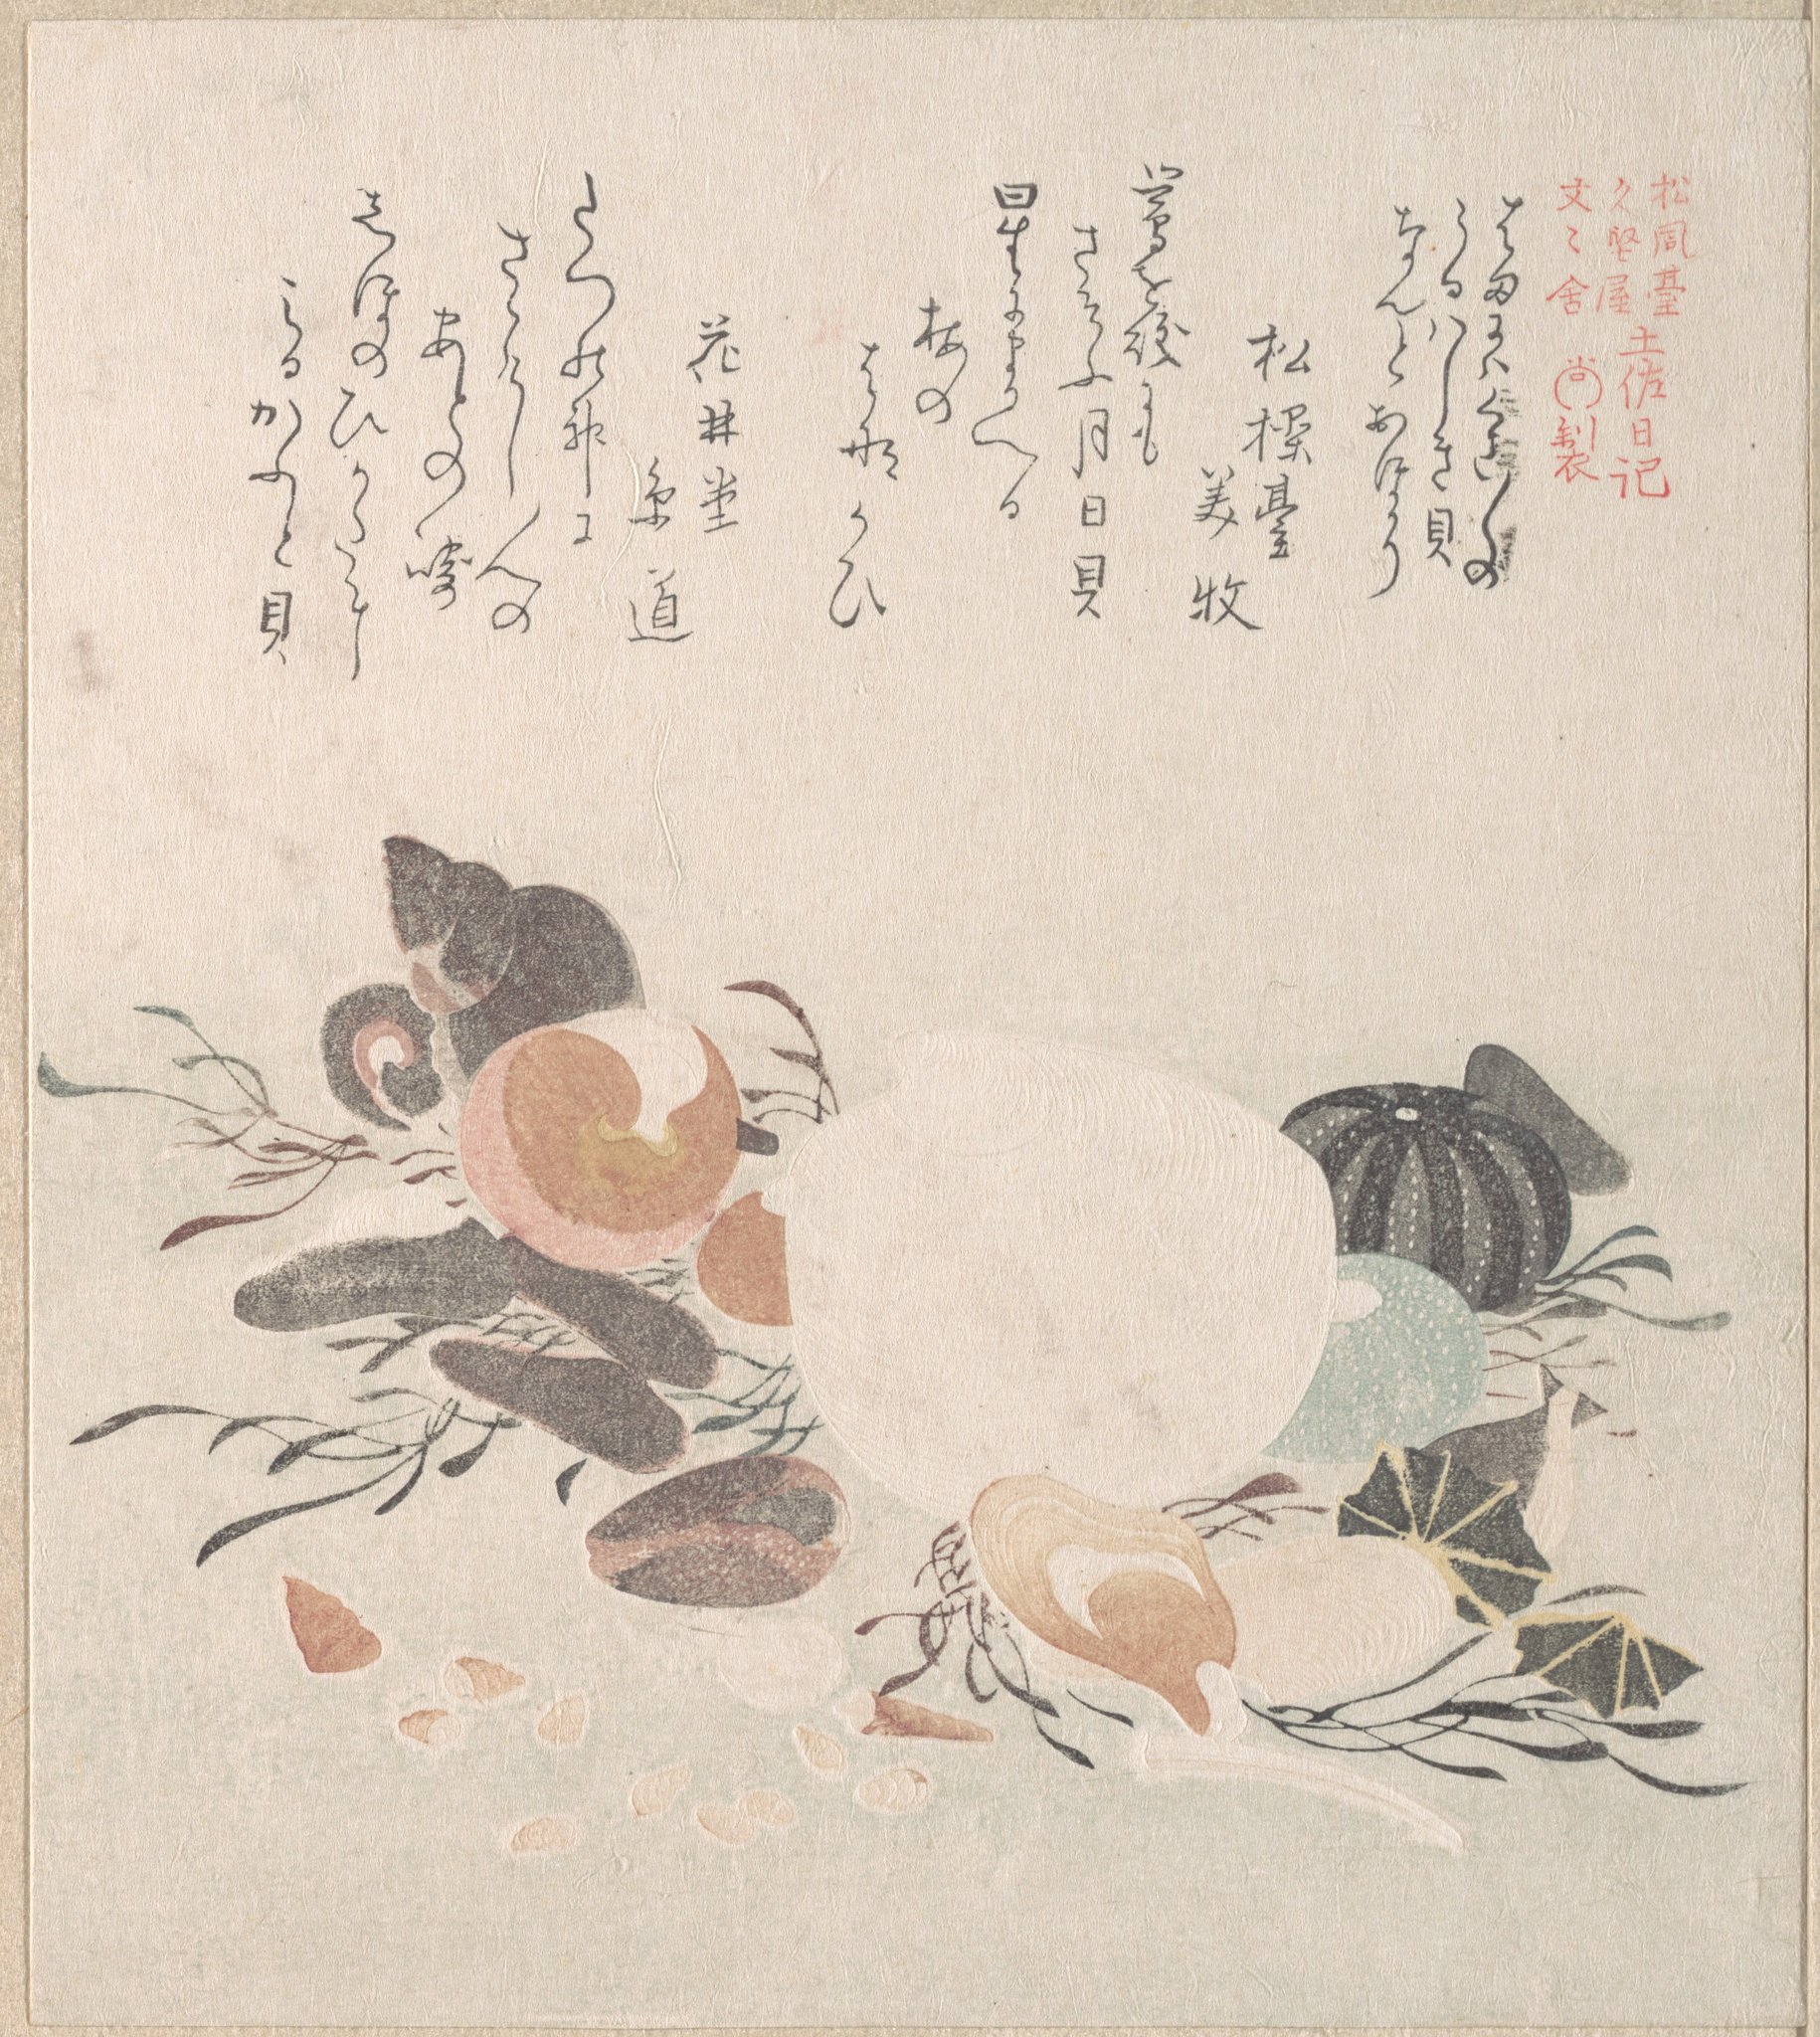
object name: print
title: Various Shells with Sea Weeds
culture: japanese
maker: kubo shunman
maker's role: artist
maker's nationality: japanese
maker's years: 1757-1820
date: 1801-1900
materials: ink, paper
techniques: surimono, woodblock print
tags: shells